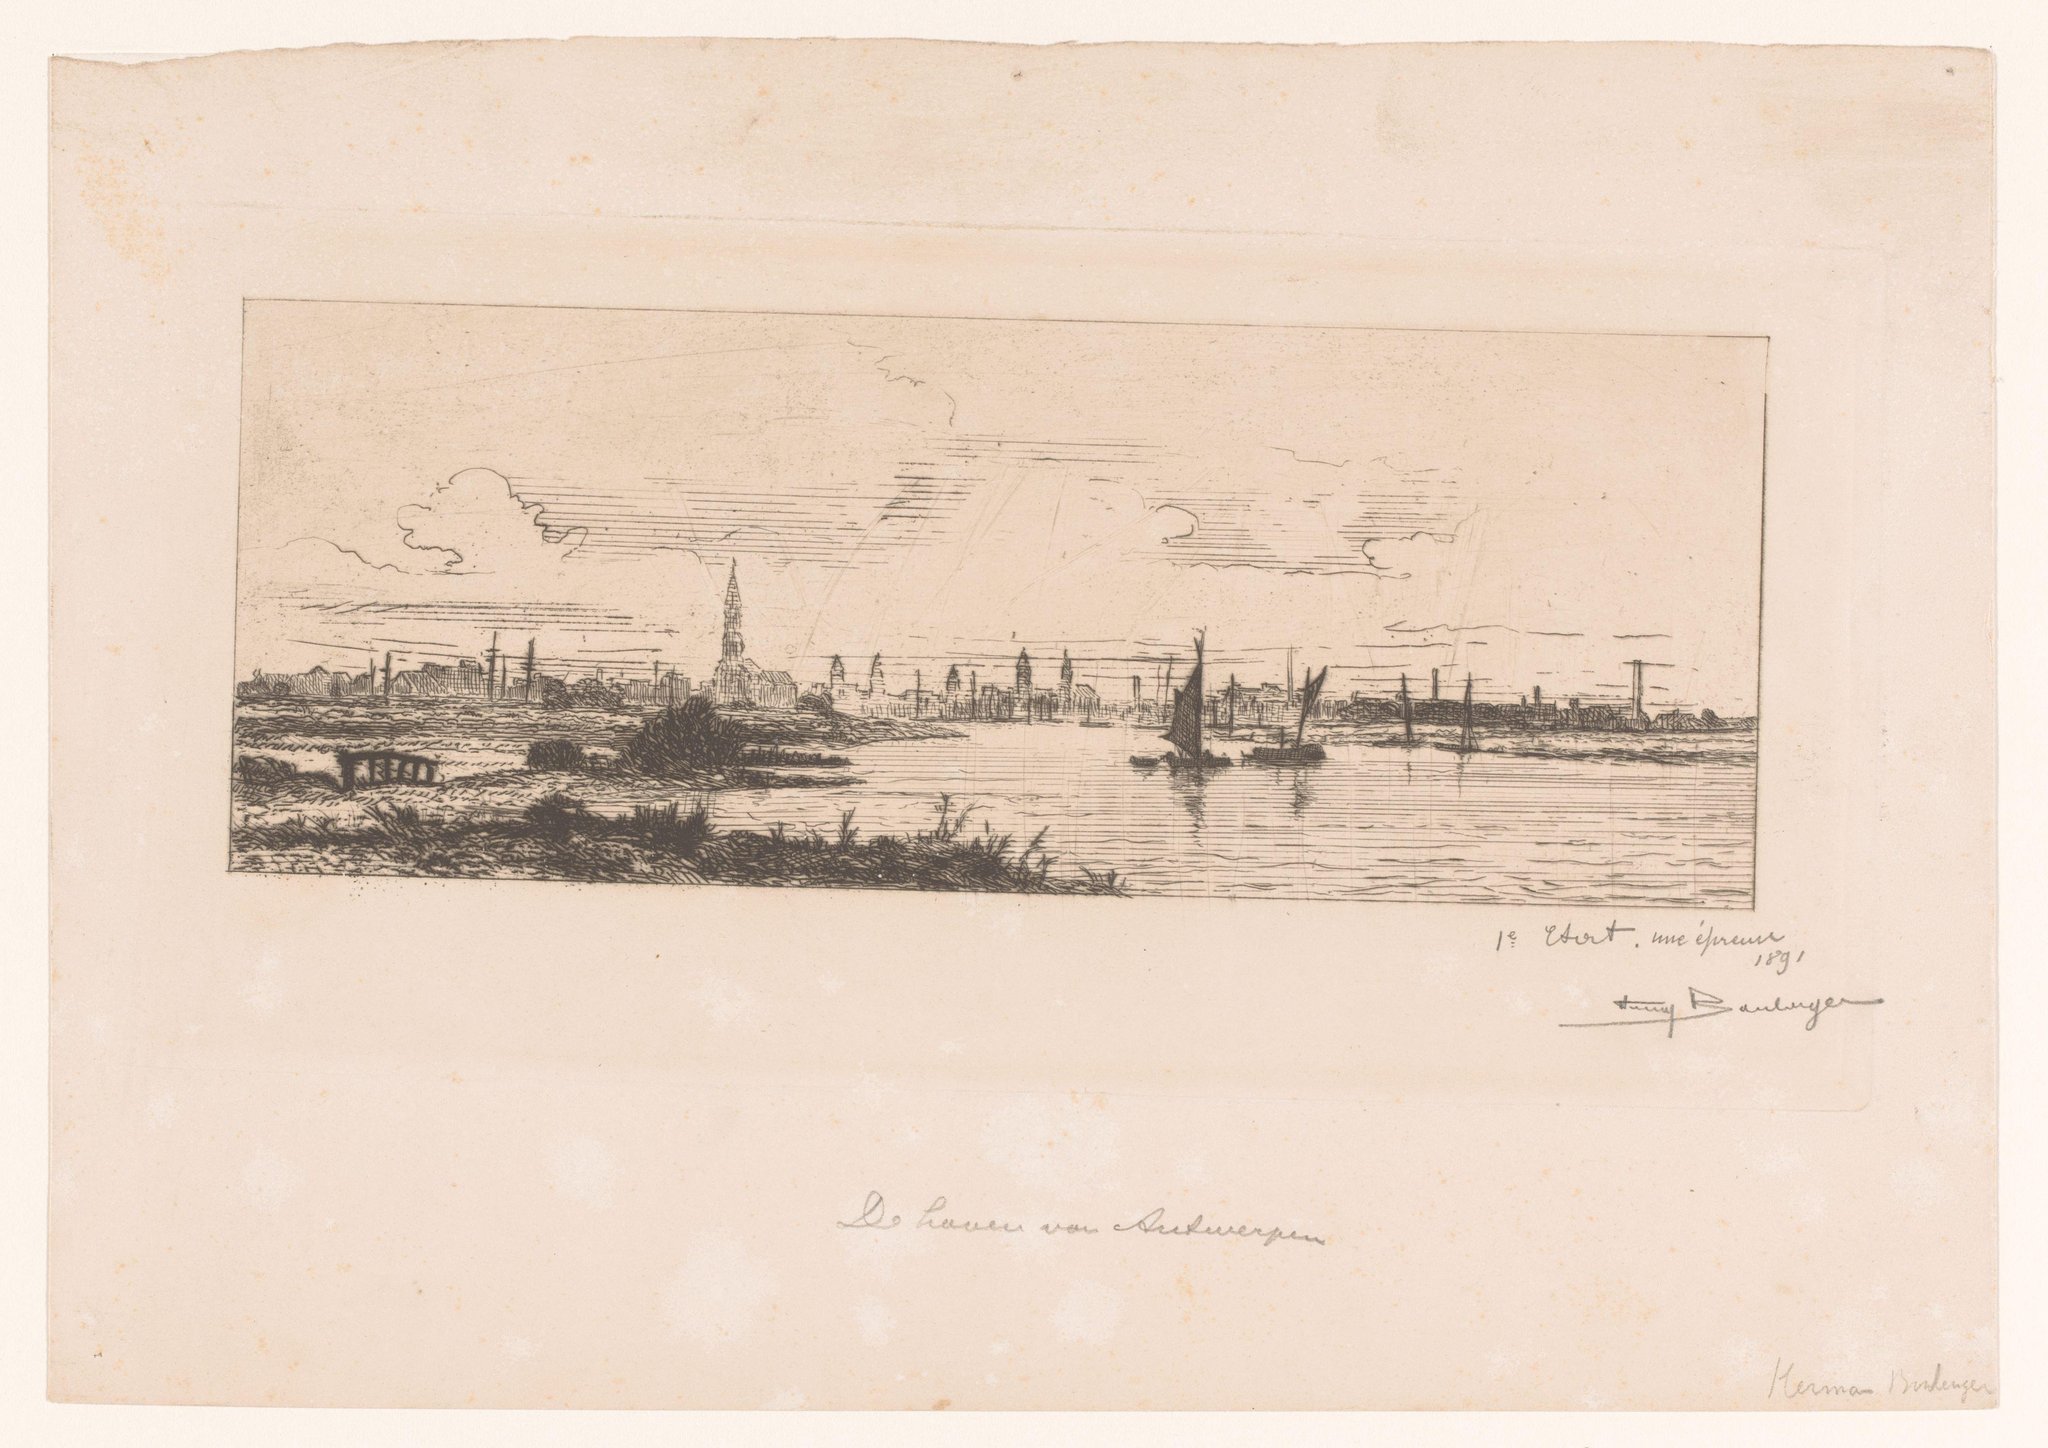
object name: print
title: Vue d'Anvers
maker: herman boulenger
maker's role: draughtsman, print maker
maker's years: 1871-1913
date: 1891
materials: paper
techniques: drypoint, etching, intaglio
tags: harbour, prospect of city, town panorama, silhouette of city, antwerp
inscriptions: collector's mark: Lugt 2228, annotation: ‘1e Etat, une épreuve’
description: Sterfdatum kunstenaar onbekend. Derhalve is voor bepaling van de rechten van dit object de vervaardigingsdatum aangehouden.